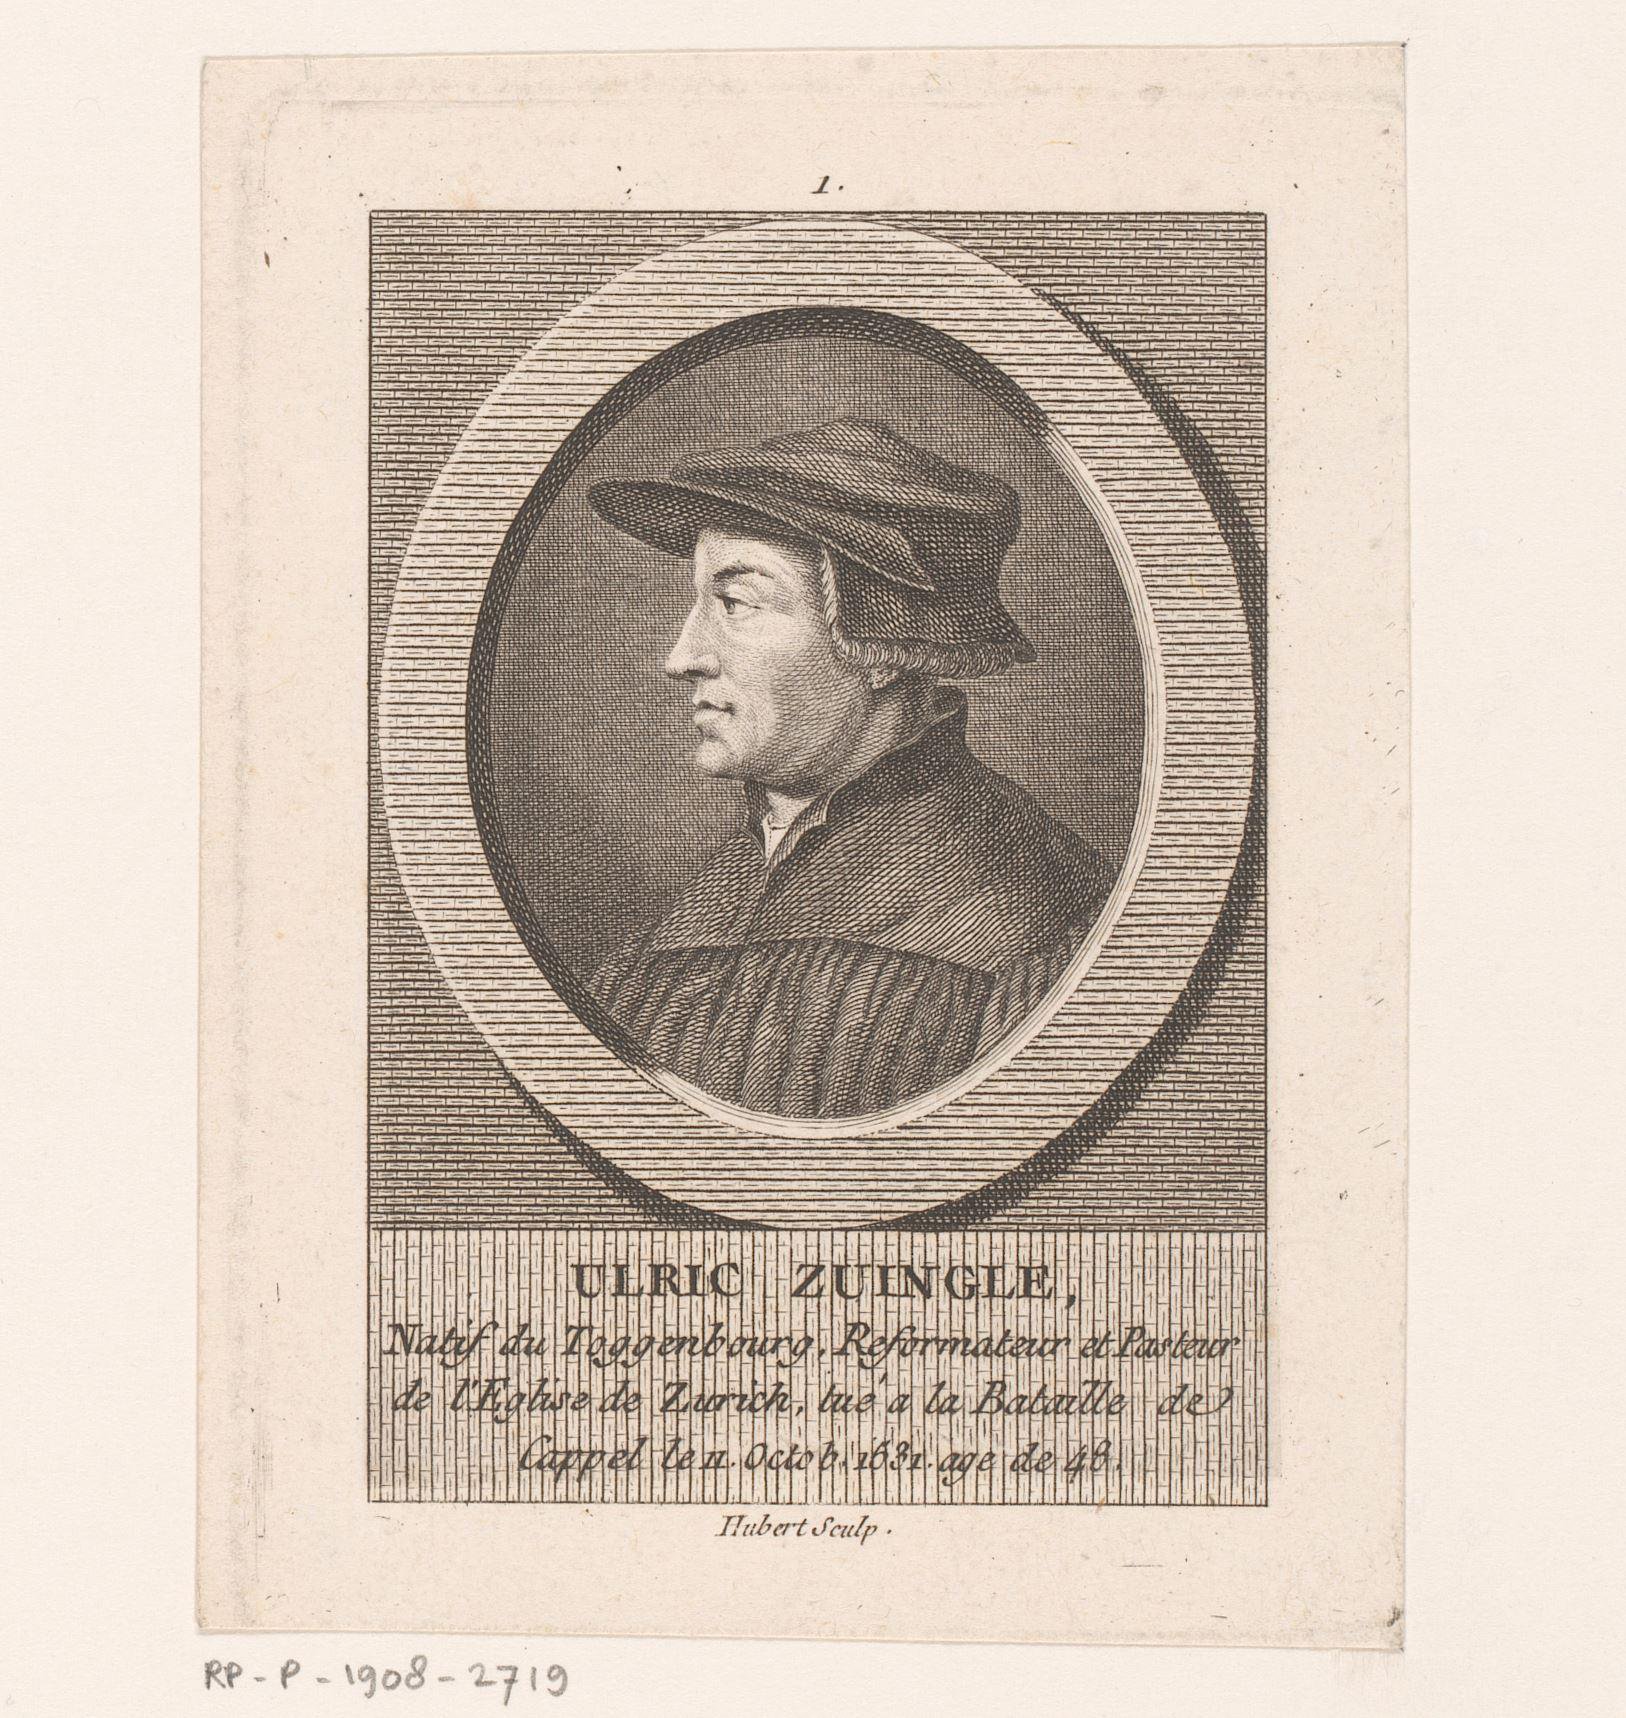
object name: book illustration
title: Portret van Ulrich Zwingli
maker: françois hubert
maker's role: print maker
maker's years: 1744-1809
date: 1784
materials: paper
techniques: engraving, etching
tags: clergyman, historical persons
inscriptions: collector's mark: Lugt 2228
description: Prent uit: Laborde, Jean-Benjamin de & Zurlauben, Beat Fidel. Tableaux topographiques, pittoresques, physiques, historiques, moraux, politiques, littéraires de la Suisse. Parijs: Lamy de Clousier, 1780-1786, dl. 3.